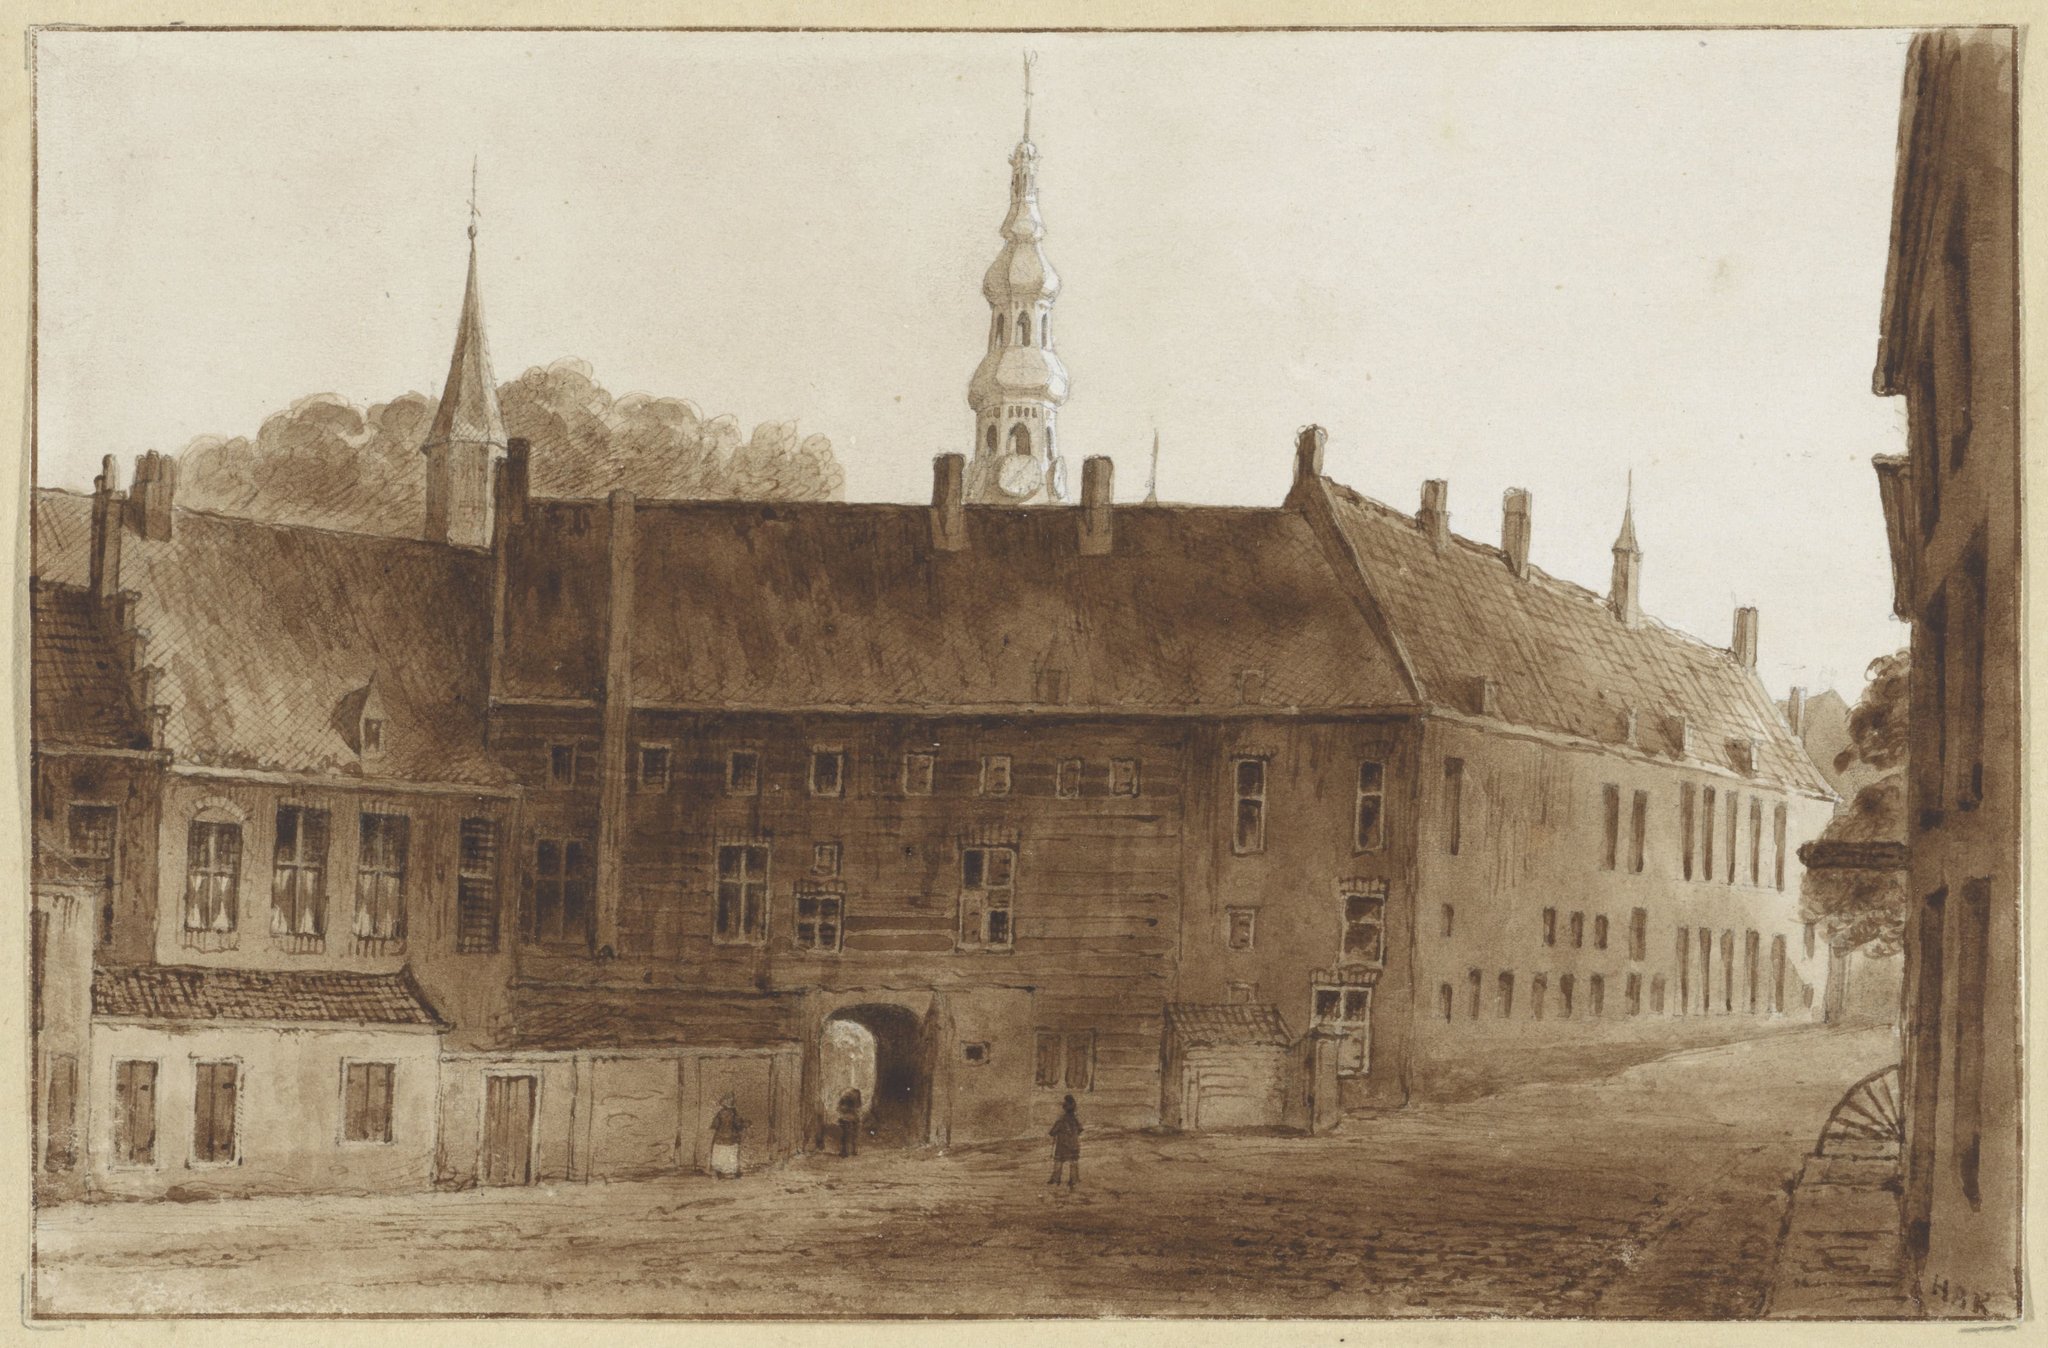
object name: drawing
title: Voorgevel van de Abdij te Middelburg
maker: hendrik abraham klinkhamer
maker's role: draughtsman, painter, print maker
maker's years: 1810-1872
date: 1853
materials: ink, paper, pencil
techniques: brush, pen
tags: abbey, monastery, convent ~ roman catholic church, façade (of house or building)